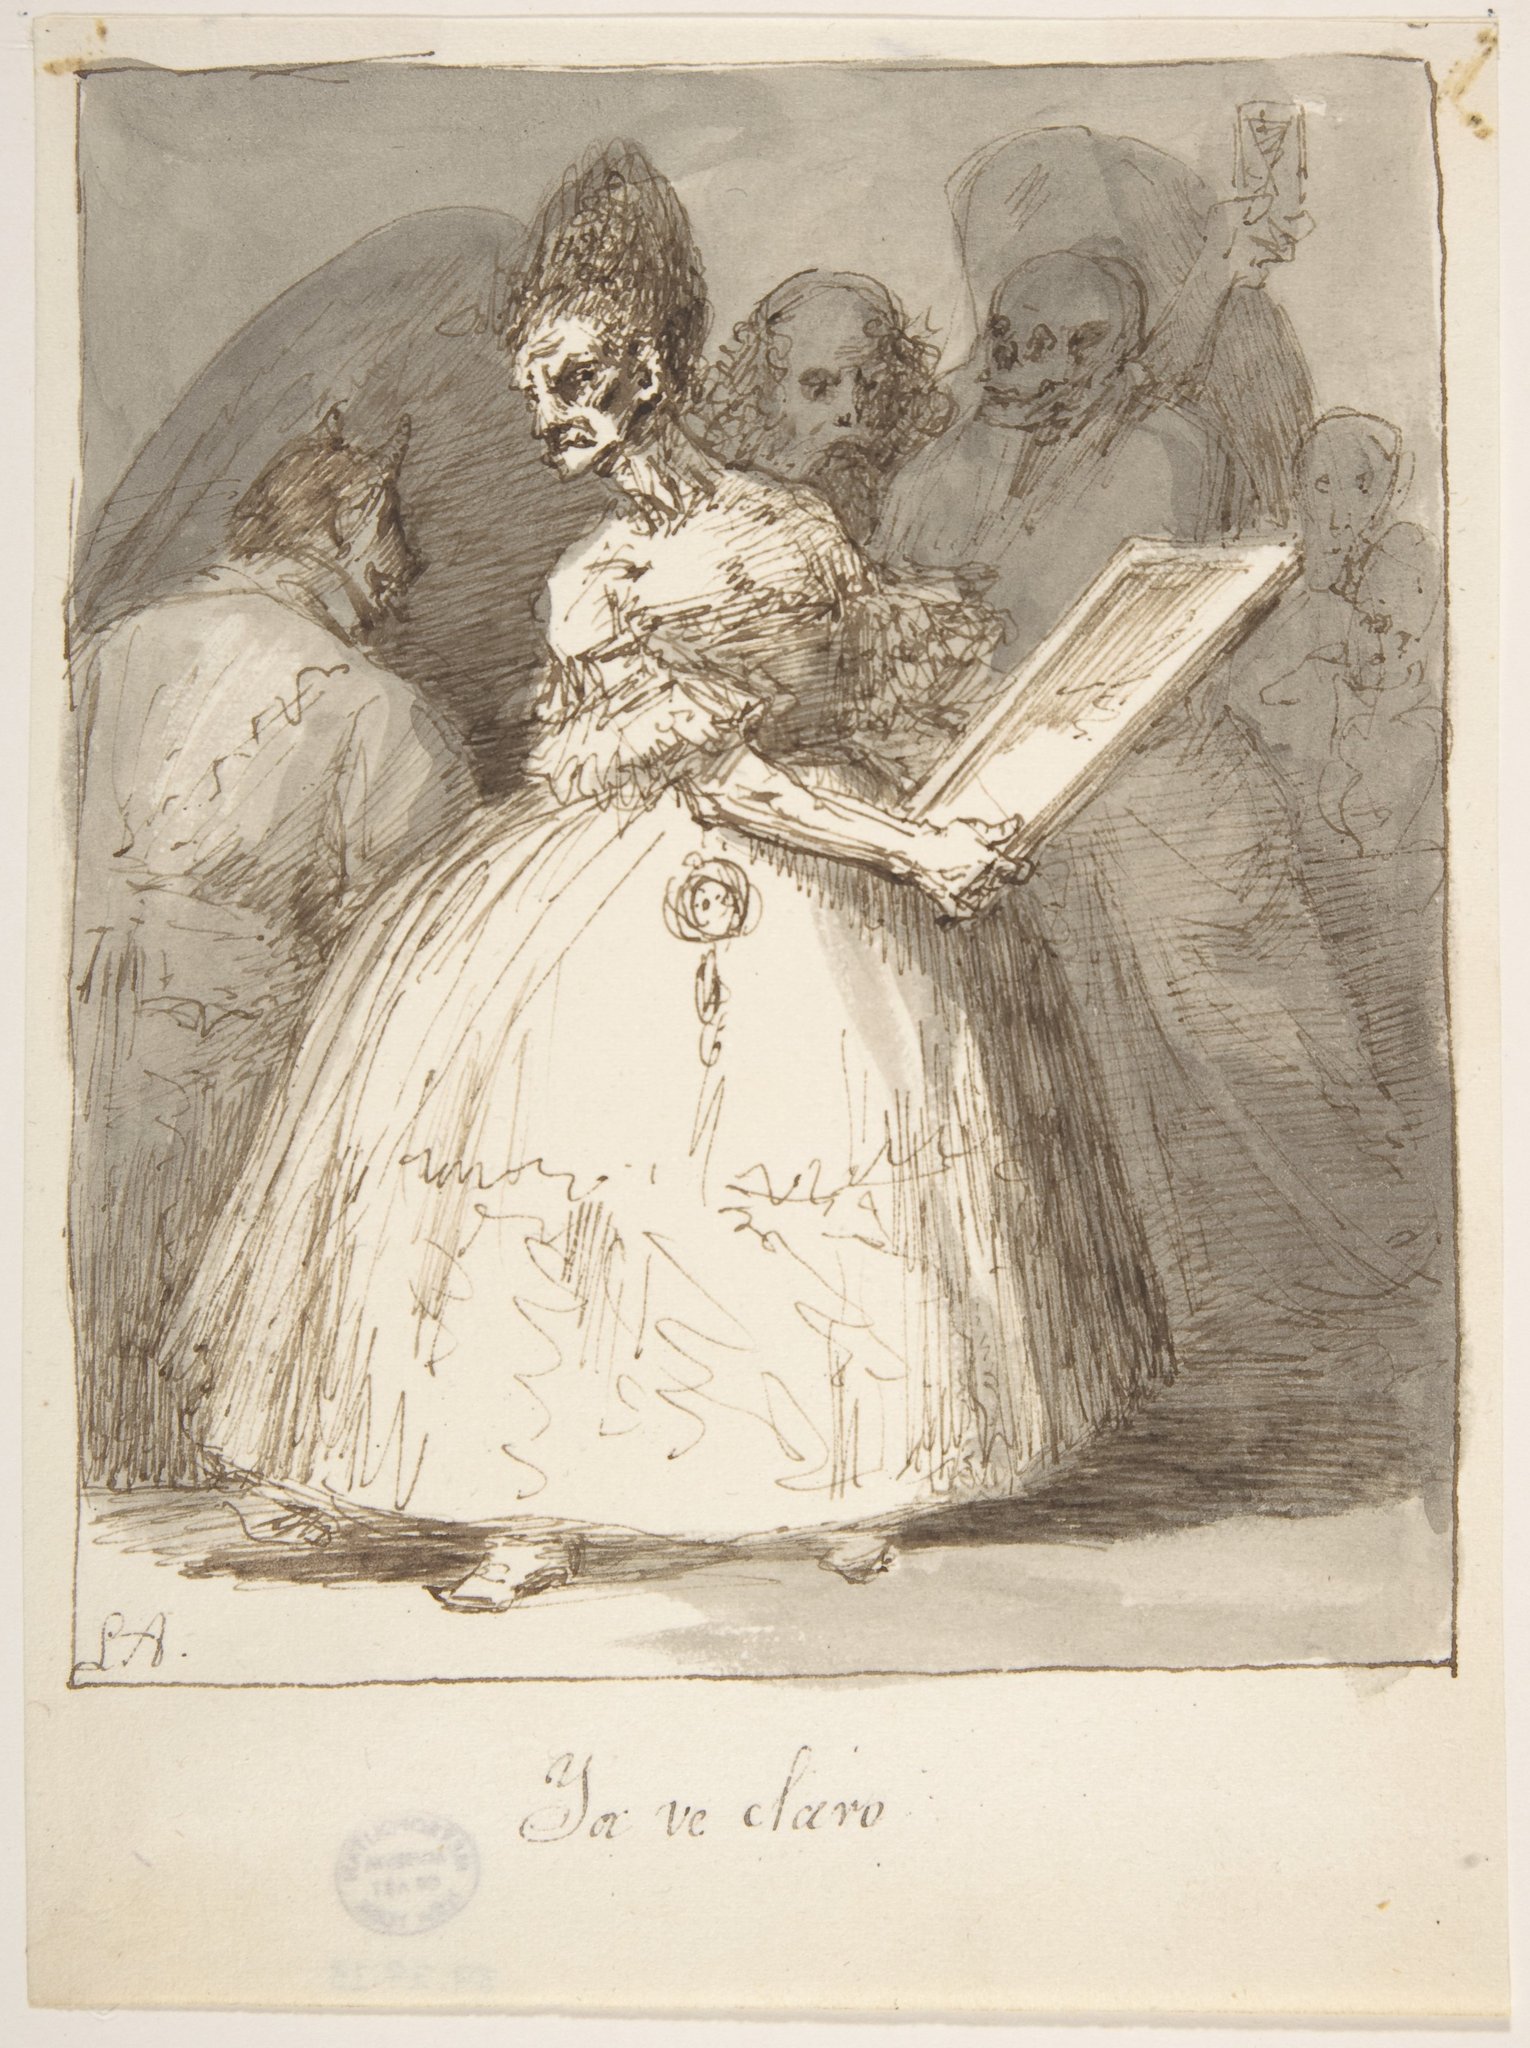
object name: drawing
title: At Last She Sees Clearly (Ya ve claro)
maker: leonardo alenza y nieto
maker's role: artist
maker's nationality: spanish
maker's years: 1807-1845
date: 1807-1845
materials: ink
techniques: pen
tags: women